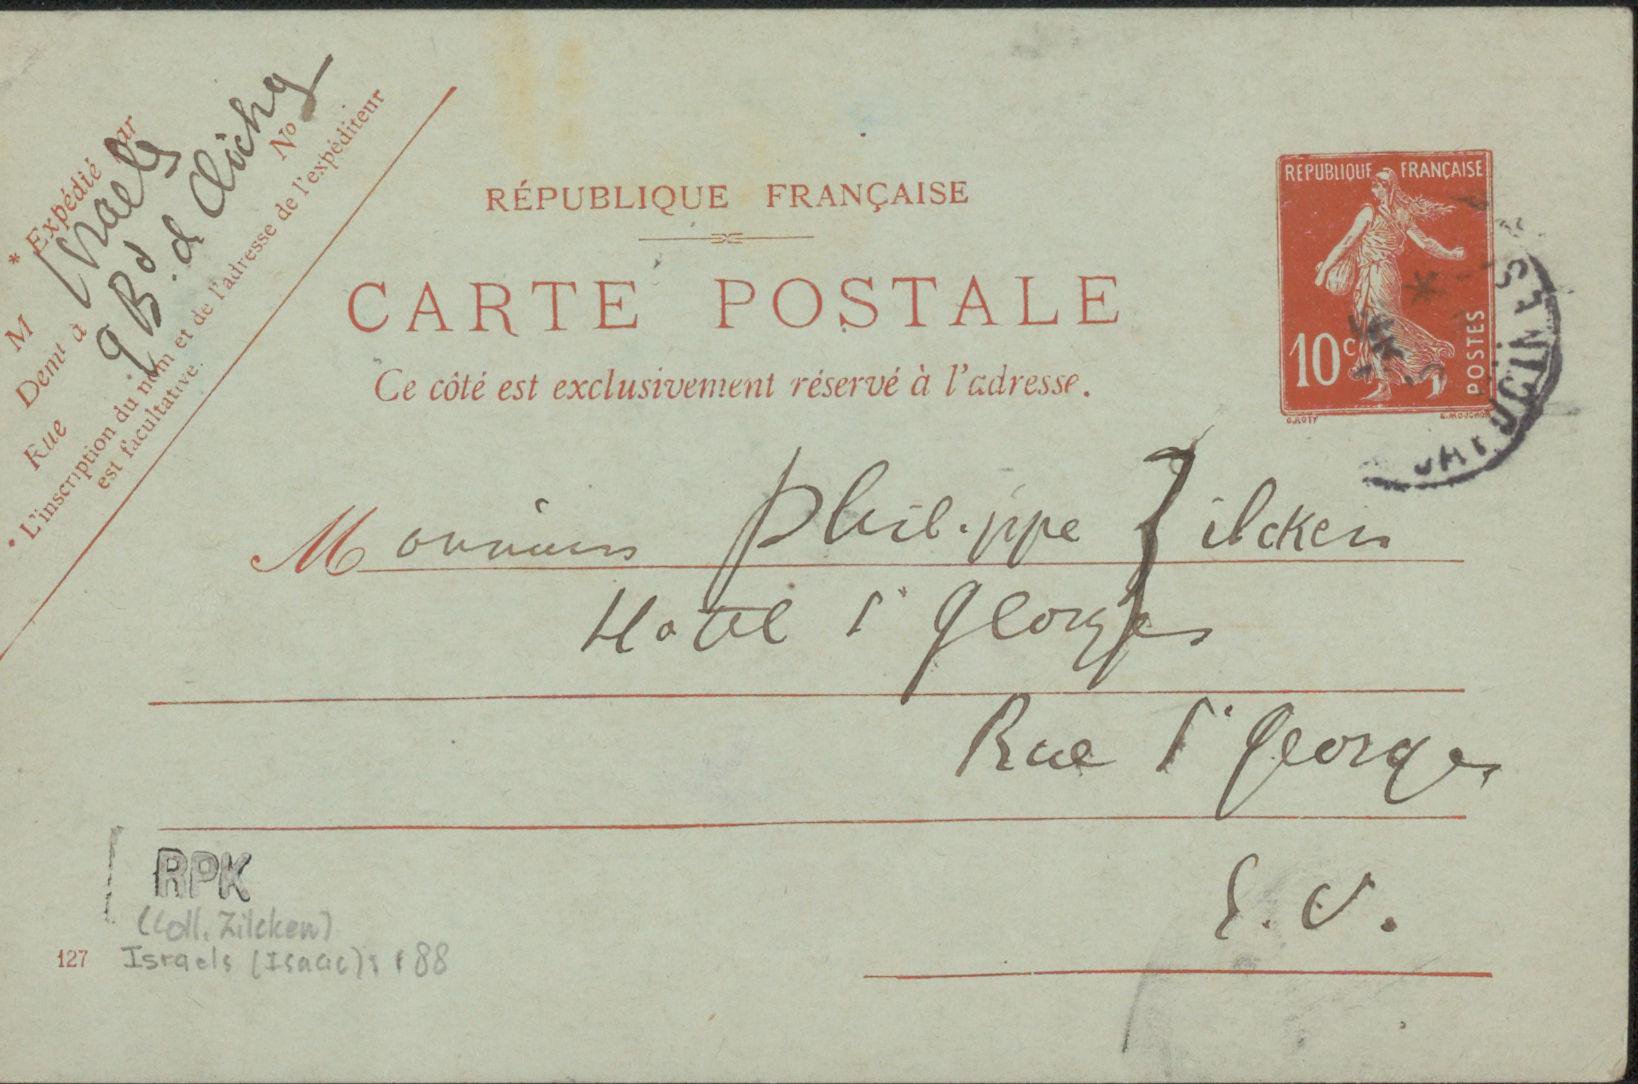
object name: postcard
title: Briefkaart aan Philip Zilcken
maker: isaac israels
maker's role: draughtsman, painter, print maker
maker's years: 1865-1934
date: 1875-1930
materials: cardboard, ink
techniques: writing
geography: paris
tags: philip zilcken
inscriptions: collector's mark: ‘RPK’